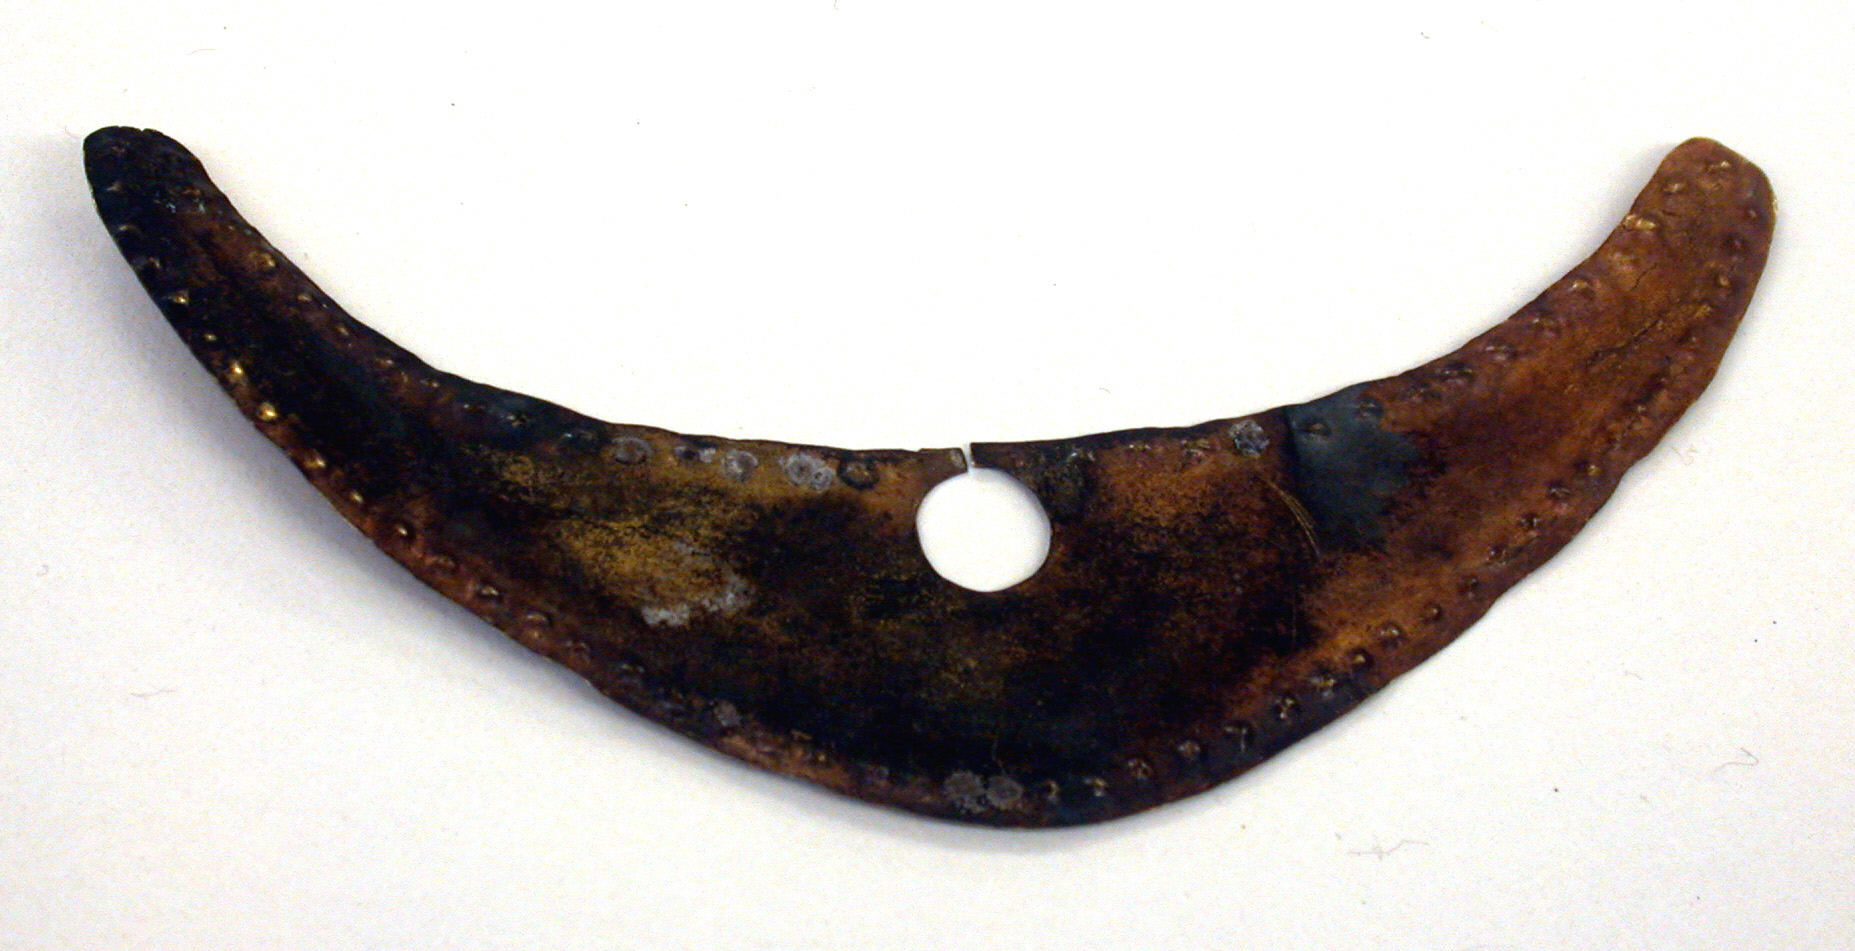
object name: nose ornament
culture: moche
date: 501-700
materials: gold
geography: peru